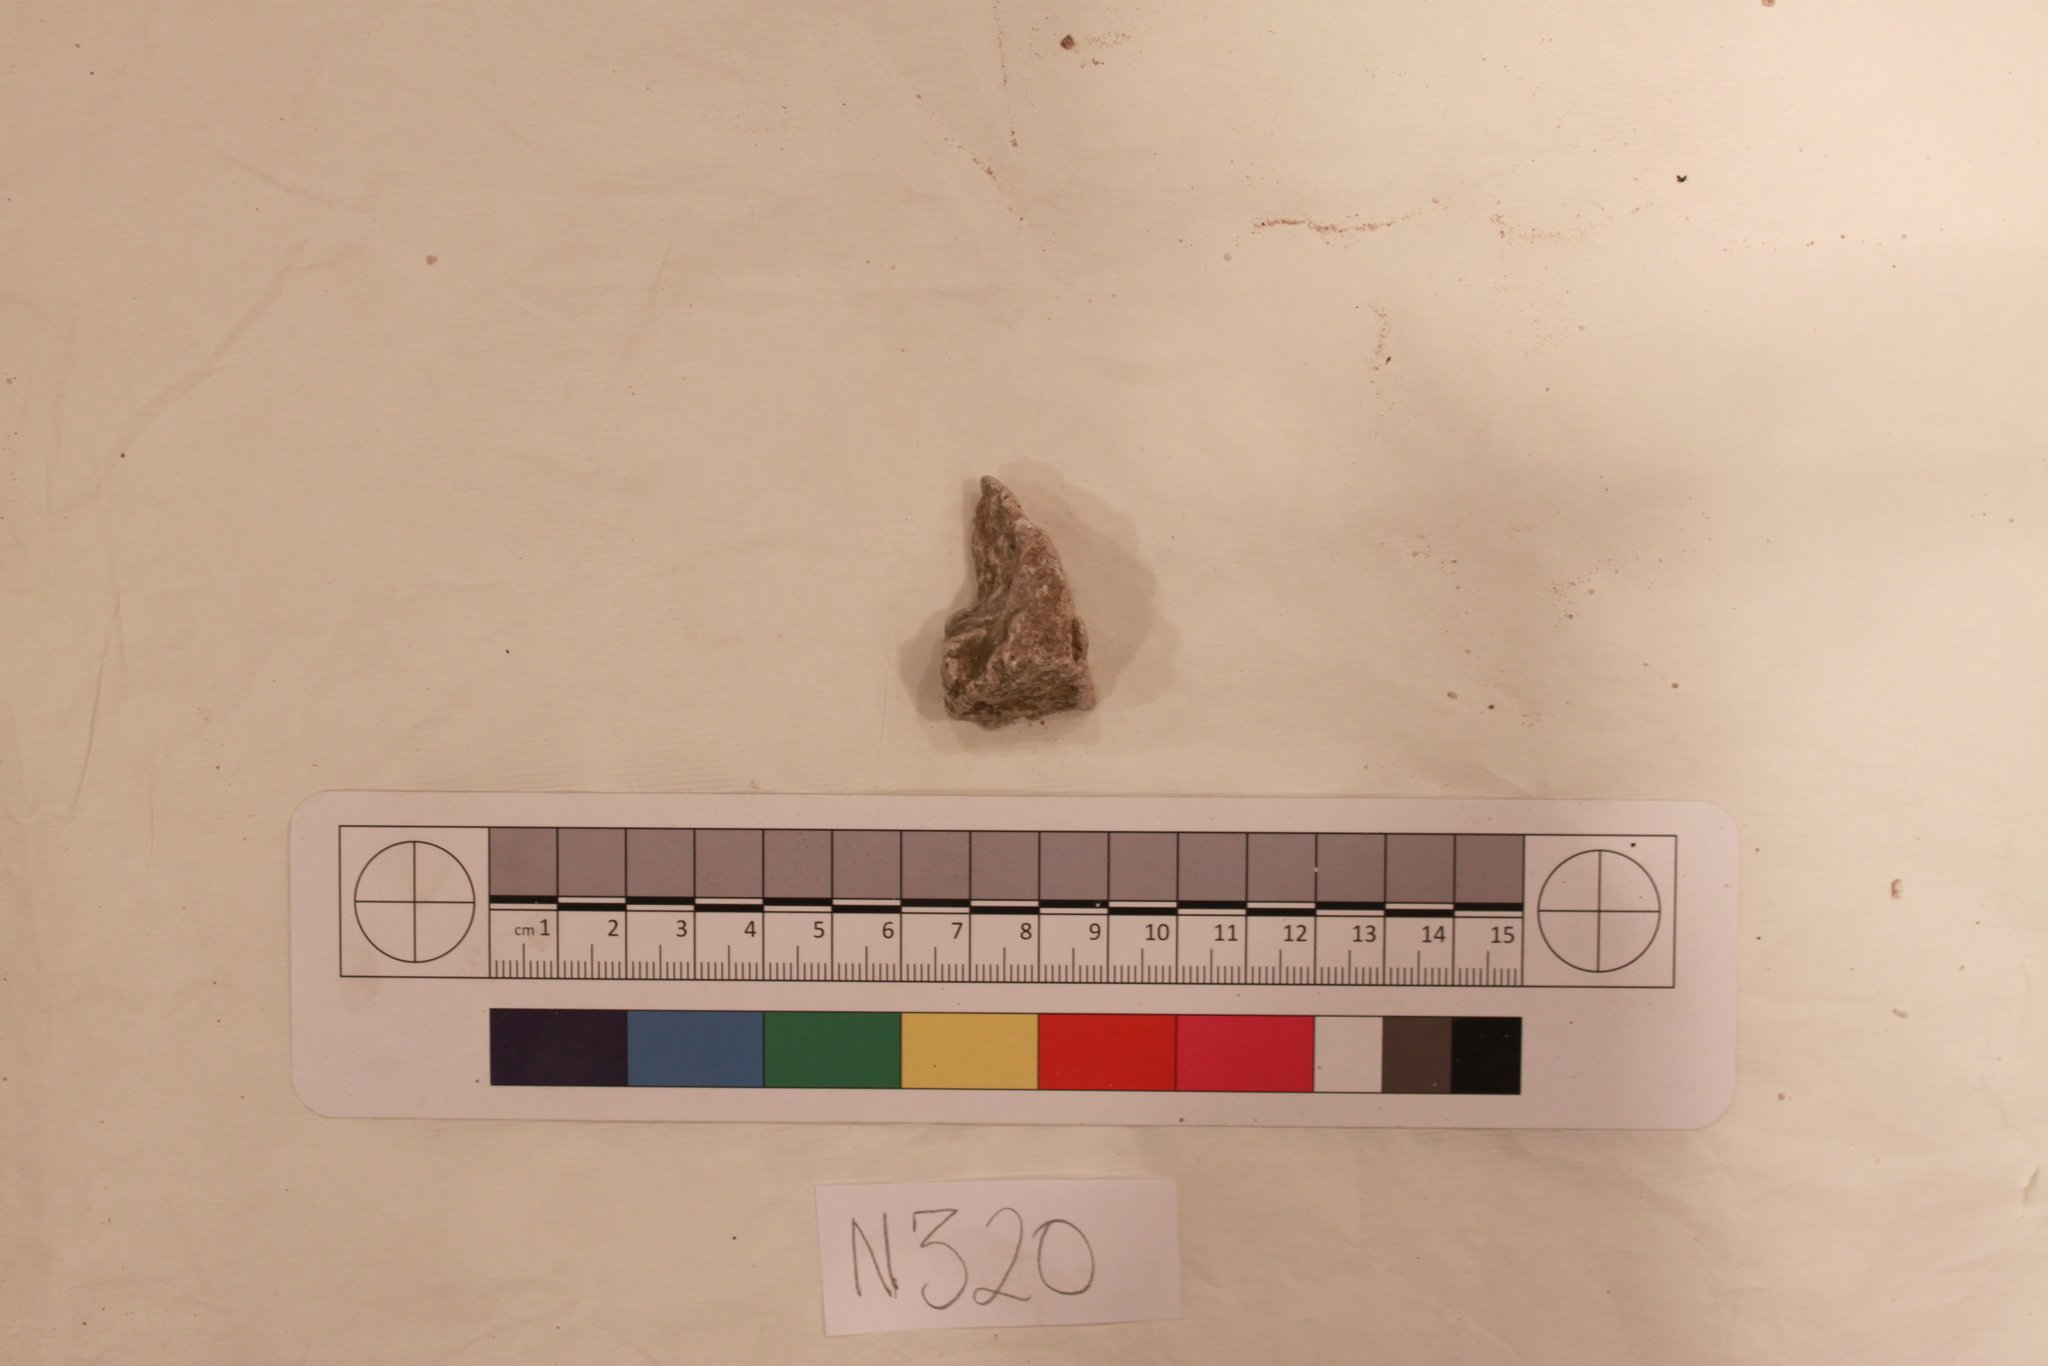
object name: fragment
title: Stucco Fragment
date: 701-1200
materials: plaster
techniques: carving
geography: iran